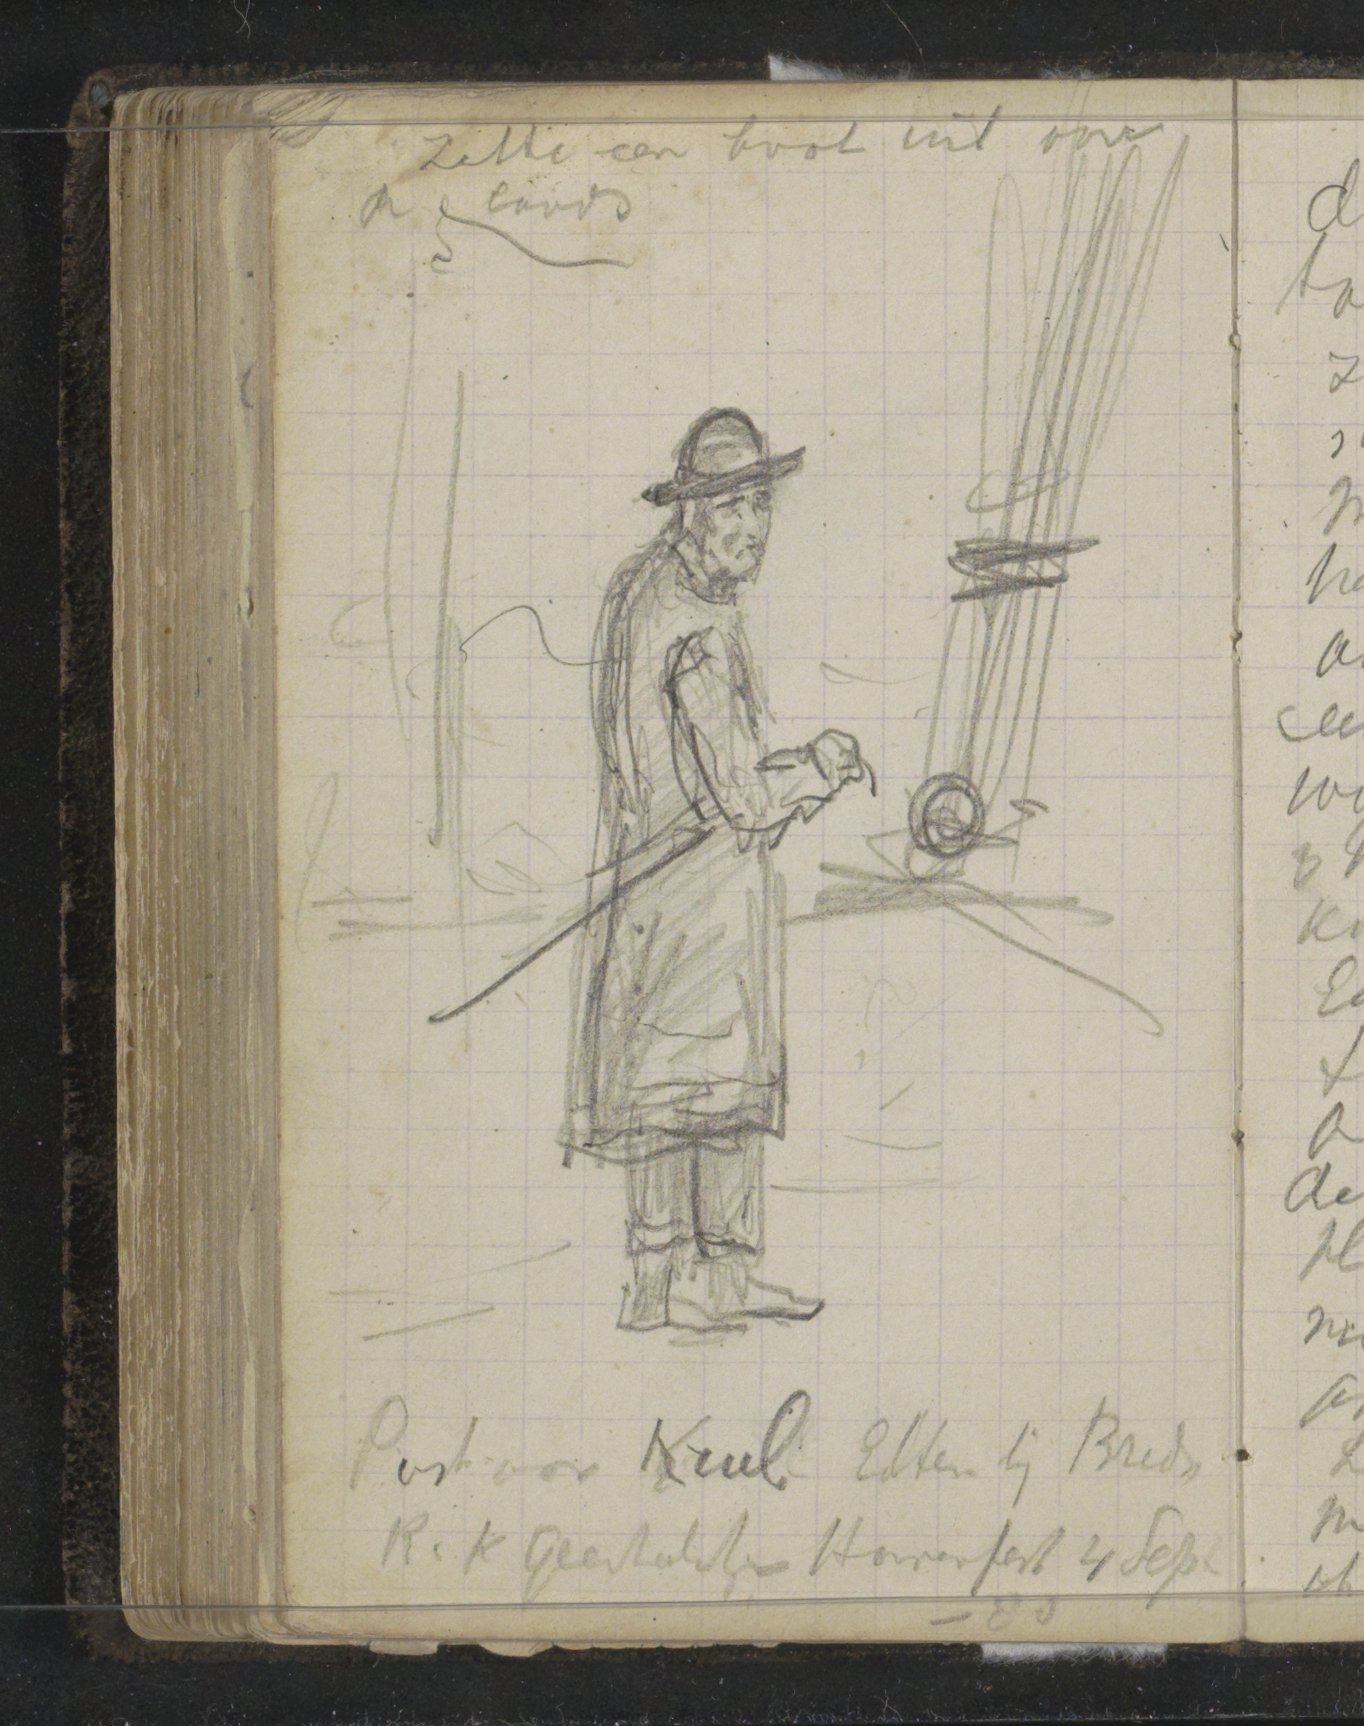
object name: sketchbook leaf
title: Pastoor Krul voor de schoener Willem Barentsz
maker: louis apol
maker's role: draughtsman, painter, print maker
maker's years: 1850-1936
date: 1880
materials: pencil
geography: hammerfest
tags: historical persons, ships (in general)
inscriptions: annotation: ‘[...] / Pastoor Krul Etten bij Breda / R.K. geestelijke Hammerfest 4 Sept / 80’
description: Blad 106 verso uit een schetsboek met 110 bladen betekend tijdens de expeditie naar Nova Zembla in 1880.